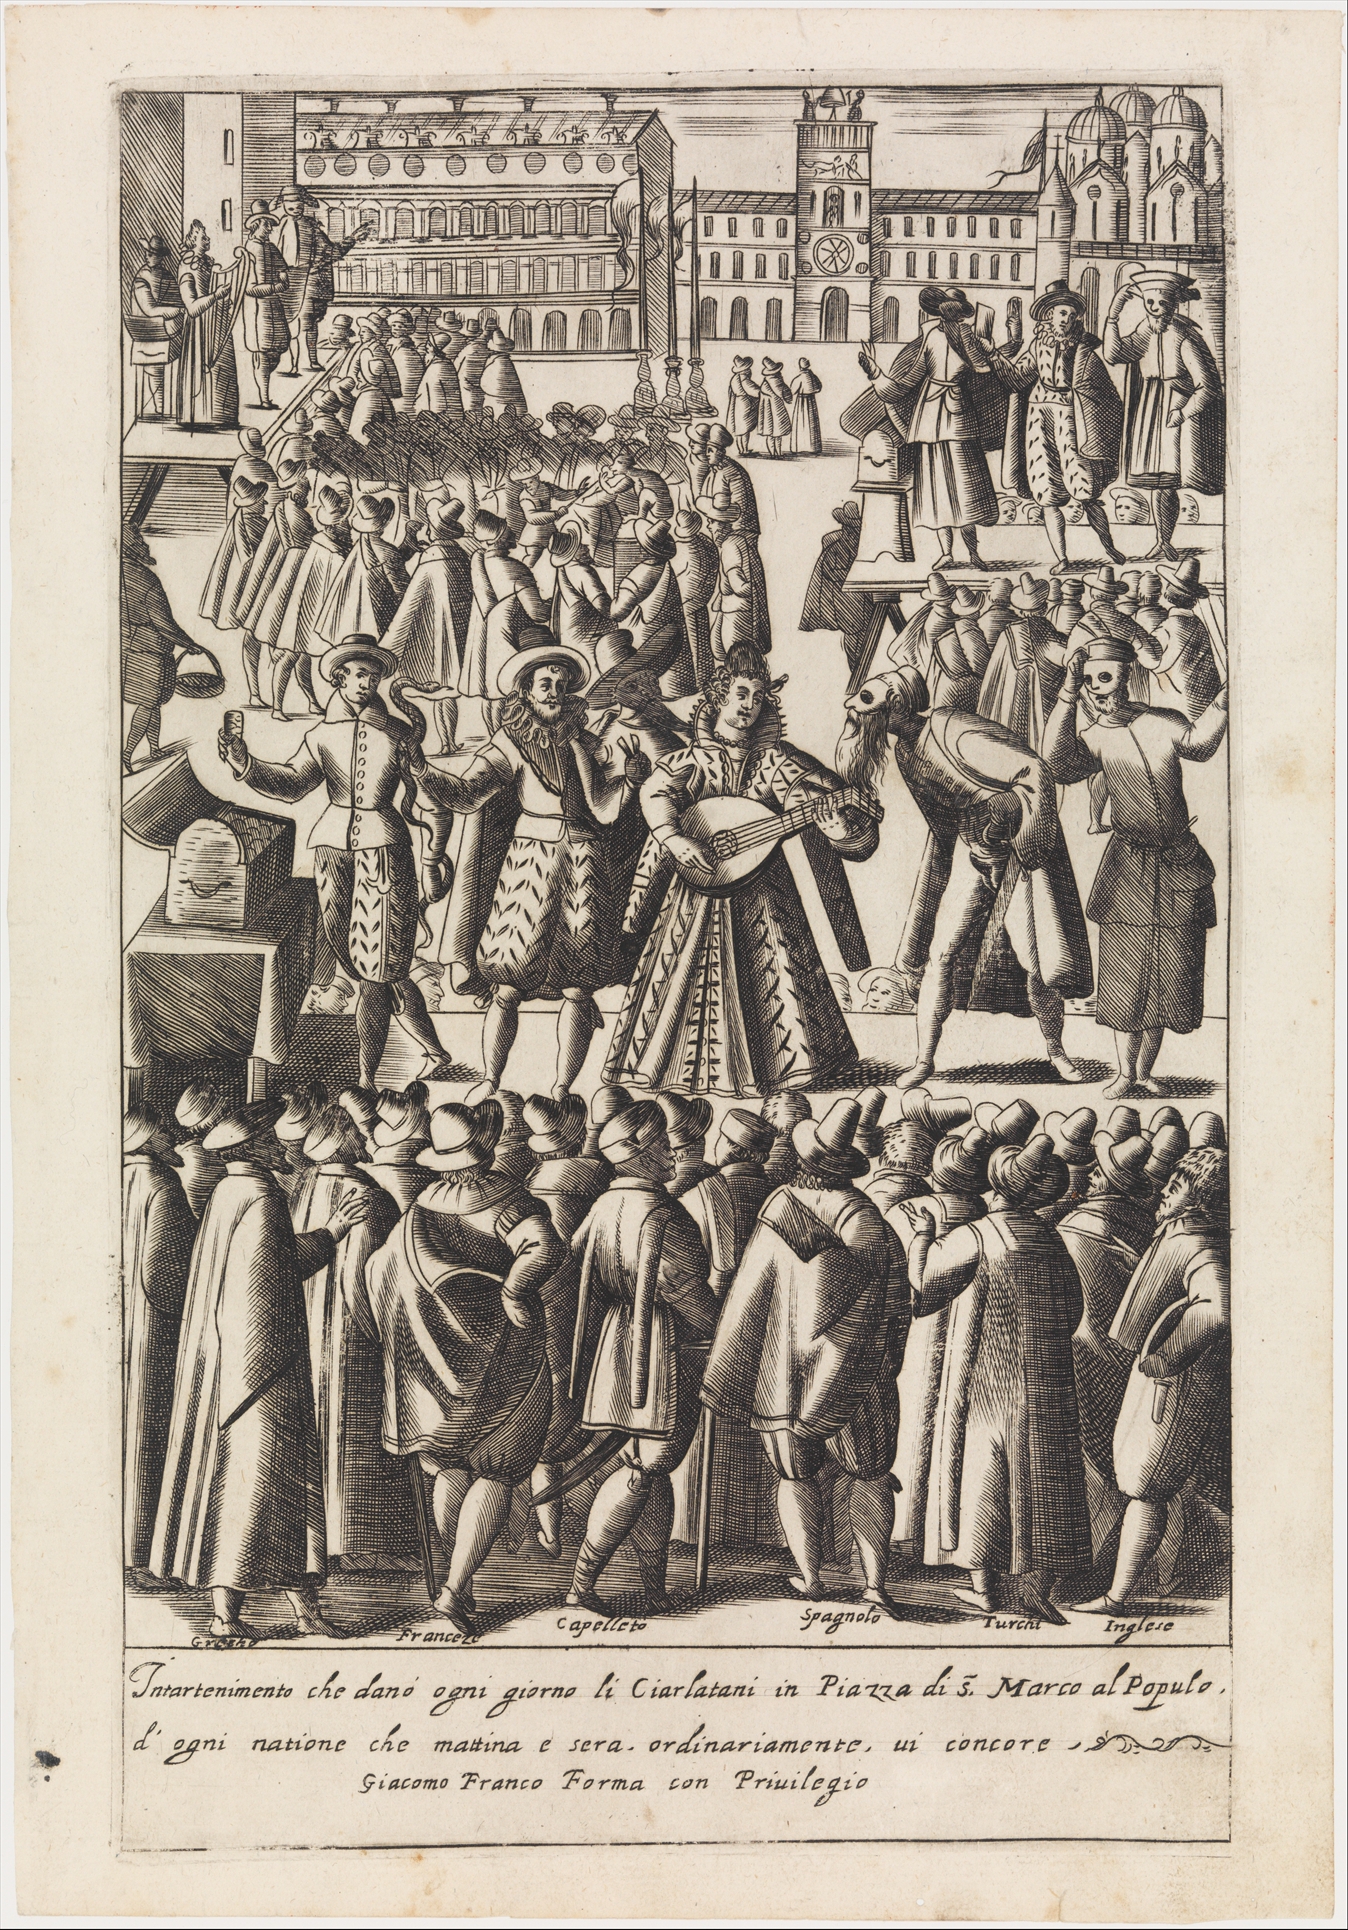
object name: print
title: Intartenimento che demo ogni giorno li Ciarlatani from Habiti d'huomeni et donne Venetiane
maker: giacomo franco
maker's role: artist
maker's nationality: italian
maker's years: 1550-1620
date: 1610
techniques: engraving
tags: buildings,guitars,crowd